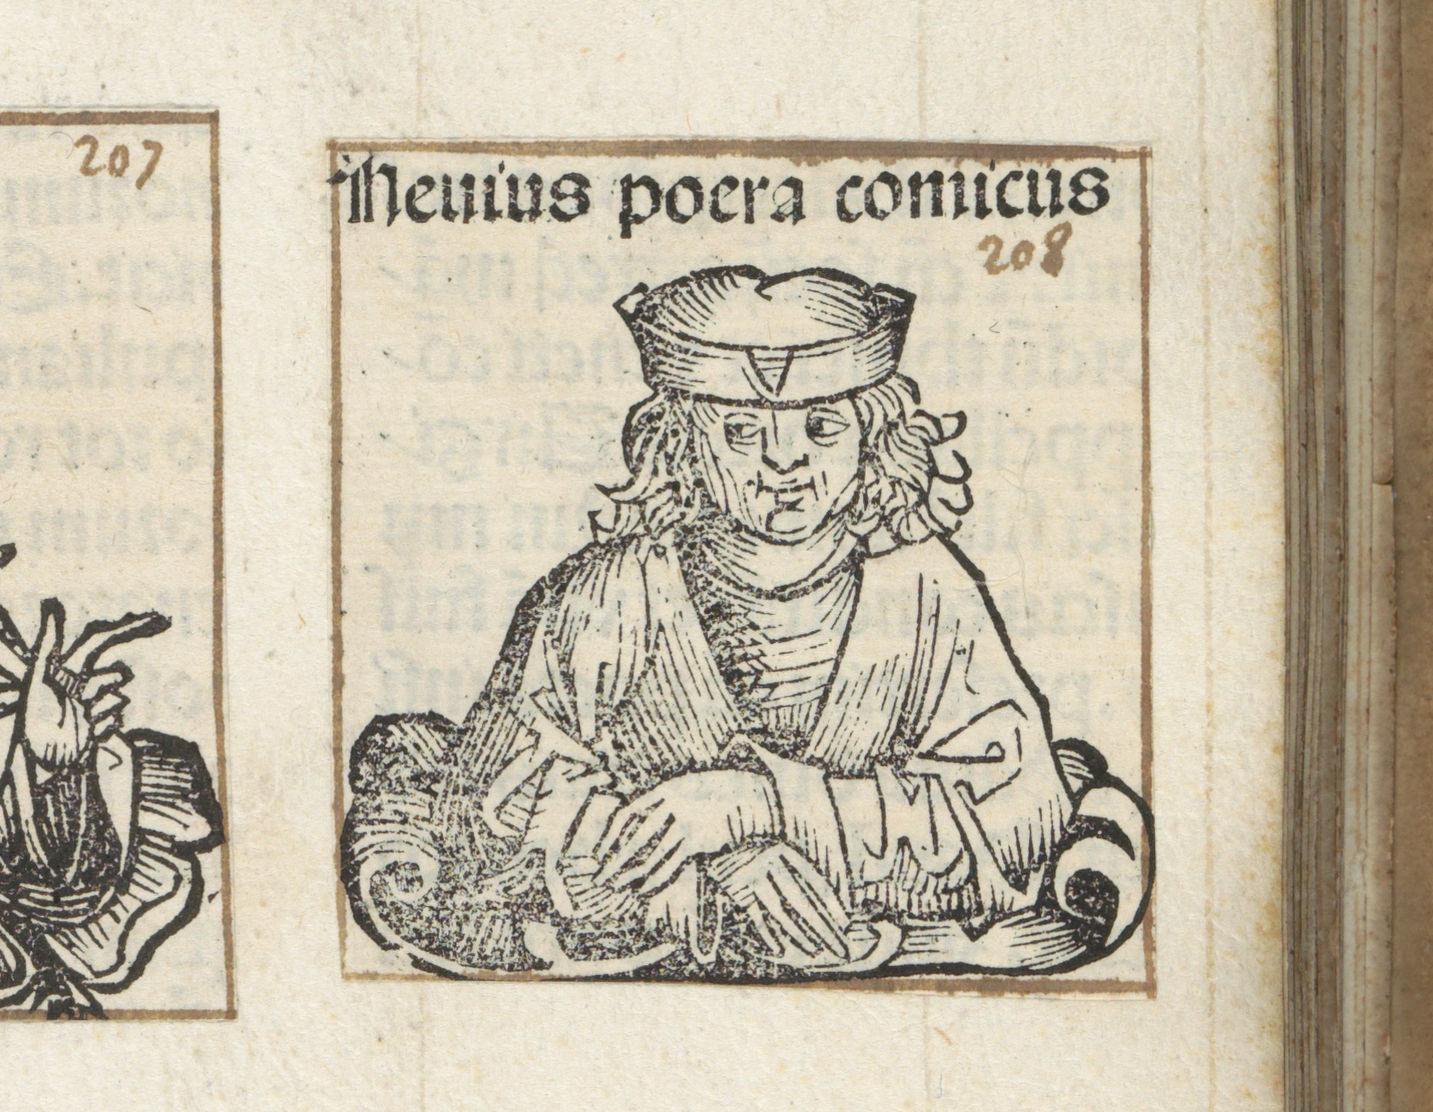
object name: book illustration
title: Gnaius Naevius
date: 1493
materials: paper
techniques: letterpress printing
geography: nuremberg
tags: male persons from classical history, writer, poet, author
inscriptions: inscription: ‘208’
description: De houtsnede wordt gebruikt als boekillustratie in de Liber Chronicarum (of Neurenbergkroniek) van Hartmann Schedel, verschenen in het Latijn en Duits in 1493. Zie de Latijnse uitgave, folio 84v.